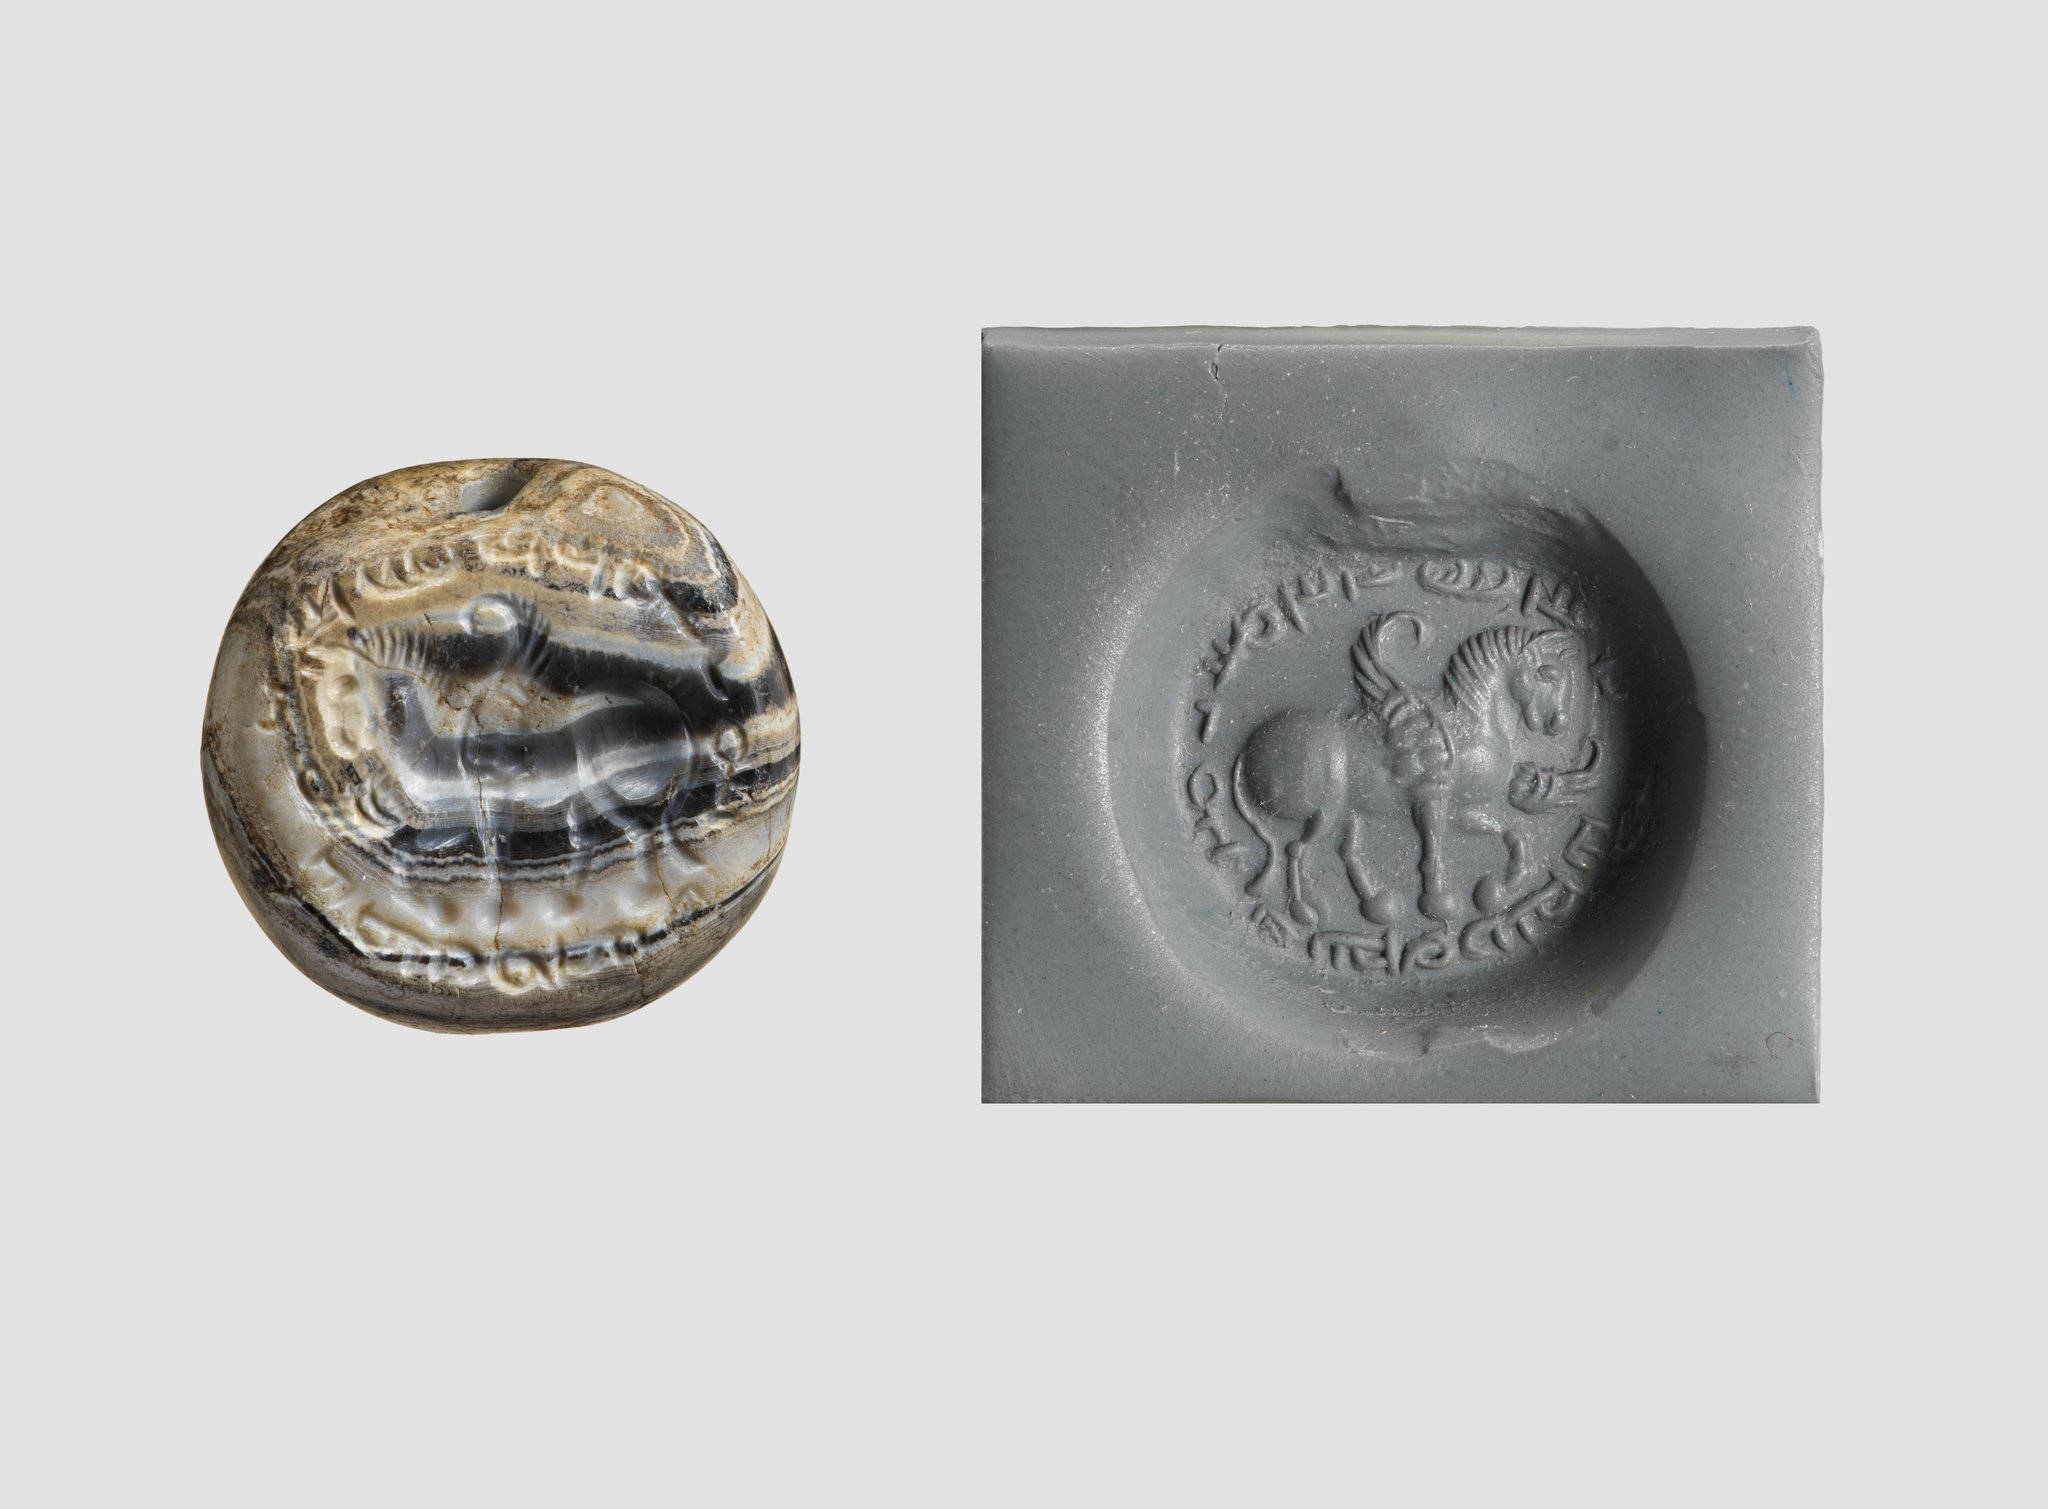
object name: stamp seal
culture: sasanian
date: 501-600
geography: iran or mesopotamia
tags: horses